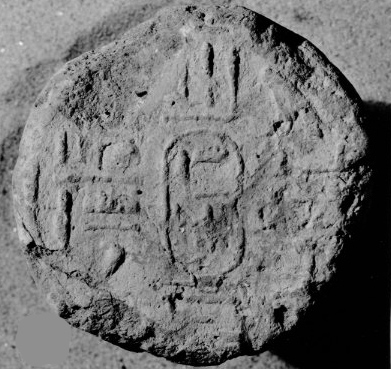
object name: cone, mahu, prophet, priest, amunet, merytamun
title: Funerary Cone of the Second Priest of Amunet Mahu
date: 1479-1400 BCE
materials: pottery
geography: egypt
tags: hieroglyphs